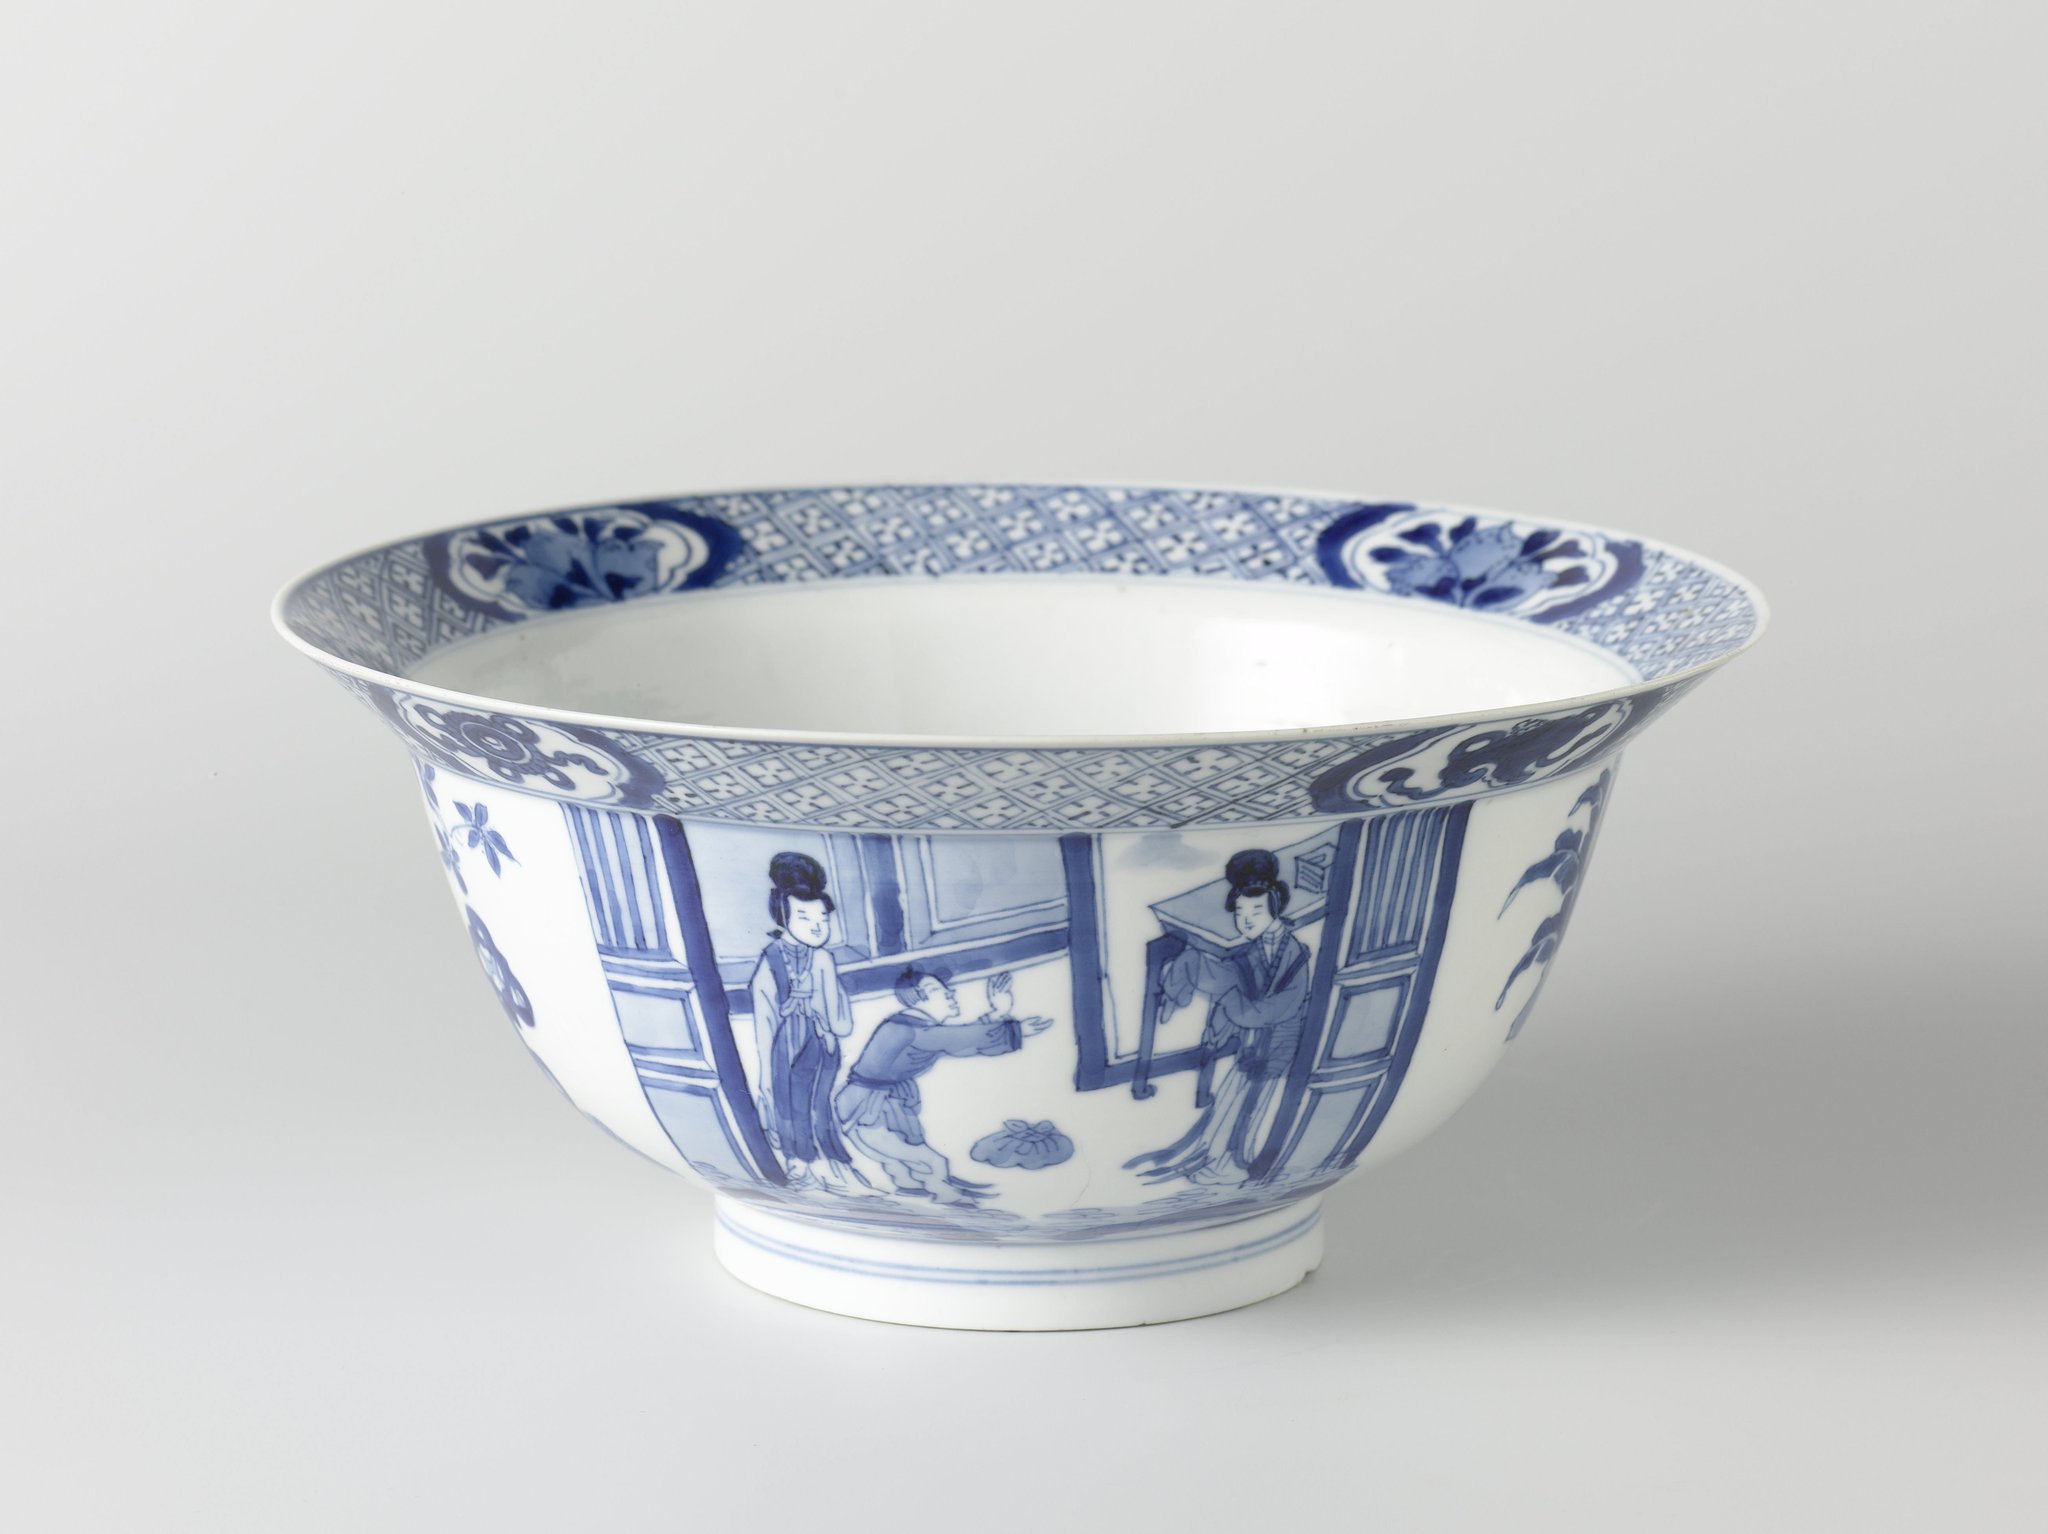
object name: bowl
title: Bowl with figures in an interior and trees near rocks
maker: Anonymous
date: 1680-1720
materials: cobalt, glaze, paint, porcelain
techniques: firing, turning, vitrification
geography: china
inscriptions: mark: ‘大 清 康 熙 年 製’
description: AK-NM-6851 Kom • Blauw-wit Kangxi-porselein • Onderdeel van Royers porseleincollectie • Mogelijk onderdeel van Huygens’ porseleincollectie • Oorspronkelijk drie exemplaren (inventaris Van der Kellen 1876) Net als het bord AK-NM-6854 is deze kom een voorbeeld van Kangxi-porselein met voorstellingen gebaseerd op houtsneden (in dit geval niet geïdentificeerd) – een voortzetting van de manier van het beschilderen van porselein in de Overgangstijd. De voorstelling loopt echter niet meer door, maar is beperkt tot twee afgebakende velden. De vorm, met de omgeslagen rand, zal zich ontwikkeld hebben uit de klapmuts uit het Kraakrepertoire. Kommen van dit formaat worden wel spoelkommen genoemd, bestemd voor het spoelen van theekopjes tussen het vullen met verschillende smaken thee. Dat ook deze vorm kom, met omgeslagen rand, die functie kon vervullen blijkt uit een schilderij dat vroeger werd toegeschreven aan Nicolaas Verkolje (1673-1746) (nu anoniem) uit circa 1715 van een theedrinkend gezelschap [Castelluccio 2013, p. 61]. Mogelijk verwierf Royer de kom uit de nalatenschap van Susanna Louise Huygens (1714-1785), zijn oudtante uit wier boedel hij veel porselein kocht. In de beschrijving van haar blauw beschilderde porselein treffen we de volgende vermelding: ‘Twee kommen met omleggende randen, vol Chineesche figuuren, binnenhuizen, en op den bodem van binnen drie kindertjes.’ Een vrij algemene omschrijving, waarvan de vorm en de drie kindertjes in ieder geval kloppen. Wel had Royer er drie en Susanna Louise maar twee. Royer zal er dus tenminste één op een andere manier verworven hebben. Het stuk heeft een fraai zes-karaktermerk ‘Kangxi’. Zie voor Chinese merken tegen de achtergrond van Royers studie van de Chinese taal de toelichting bij AK-NM-6854. Bronnen: Stephane Castelluccio, Collecting Chinese and Japanese porcelain in pre-revolutionary Paris, Los Angeles, 2013.